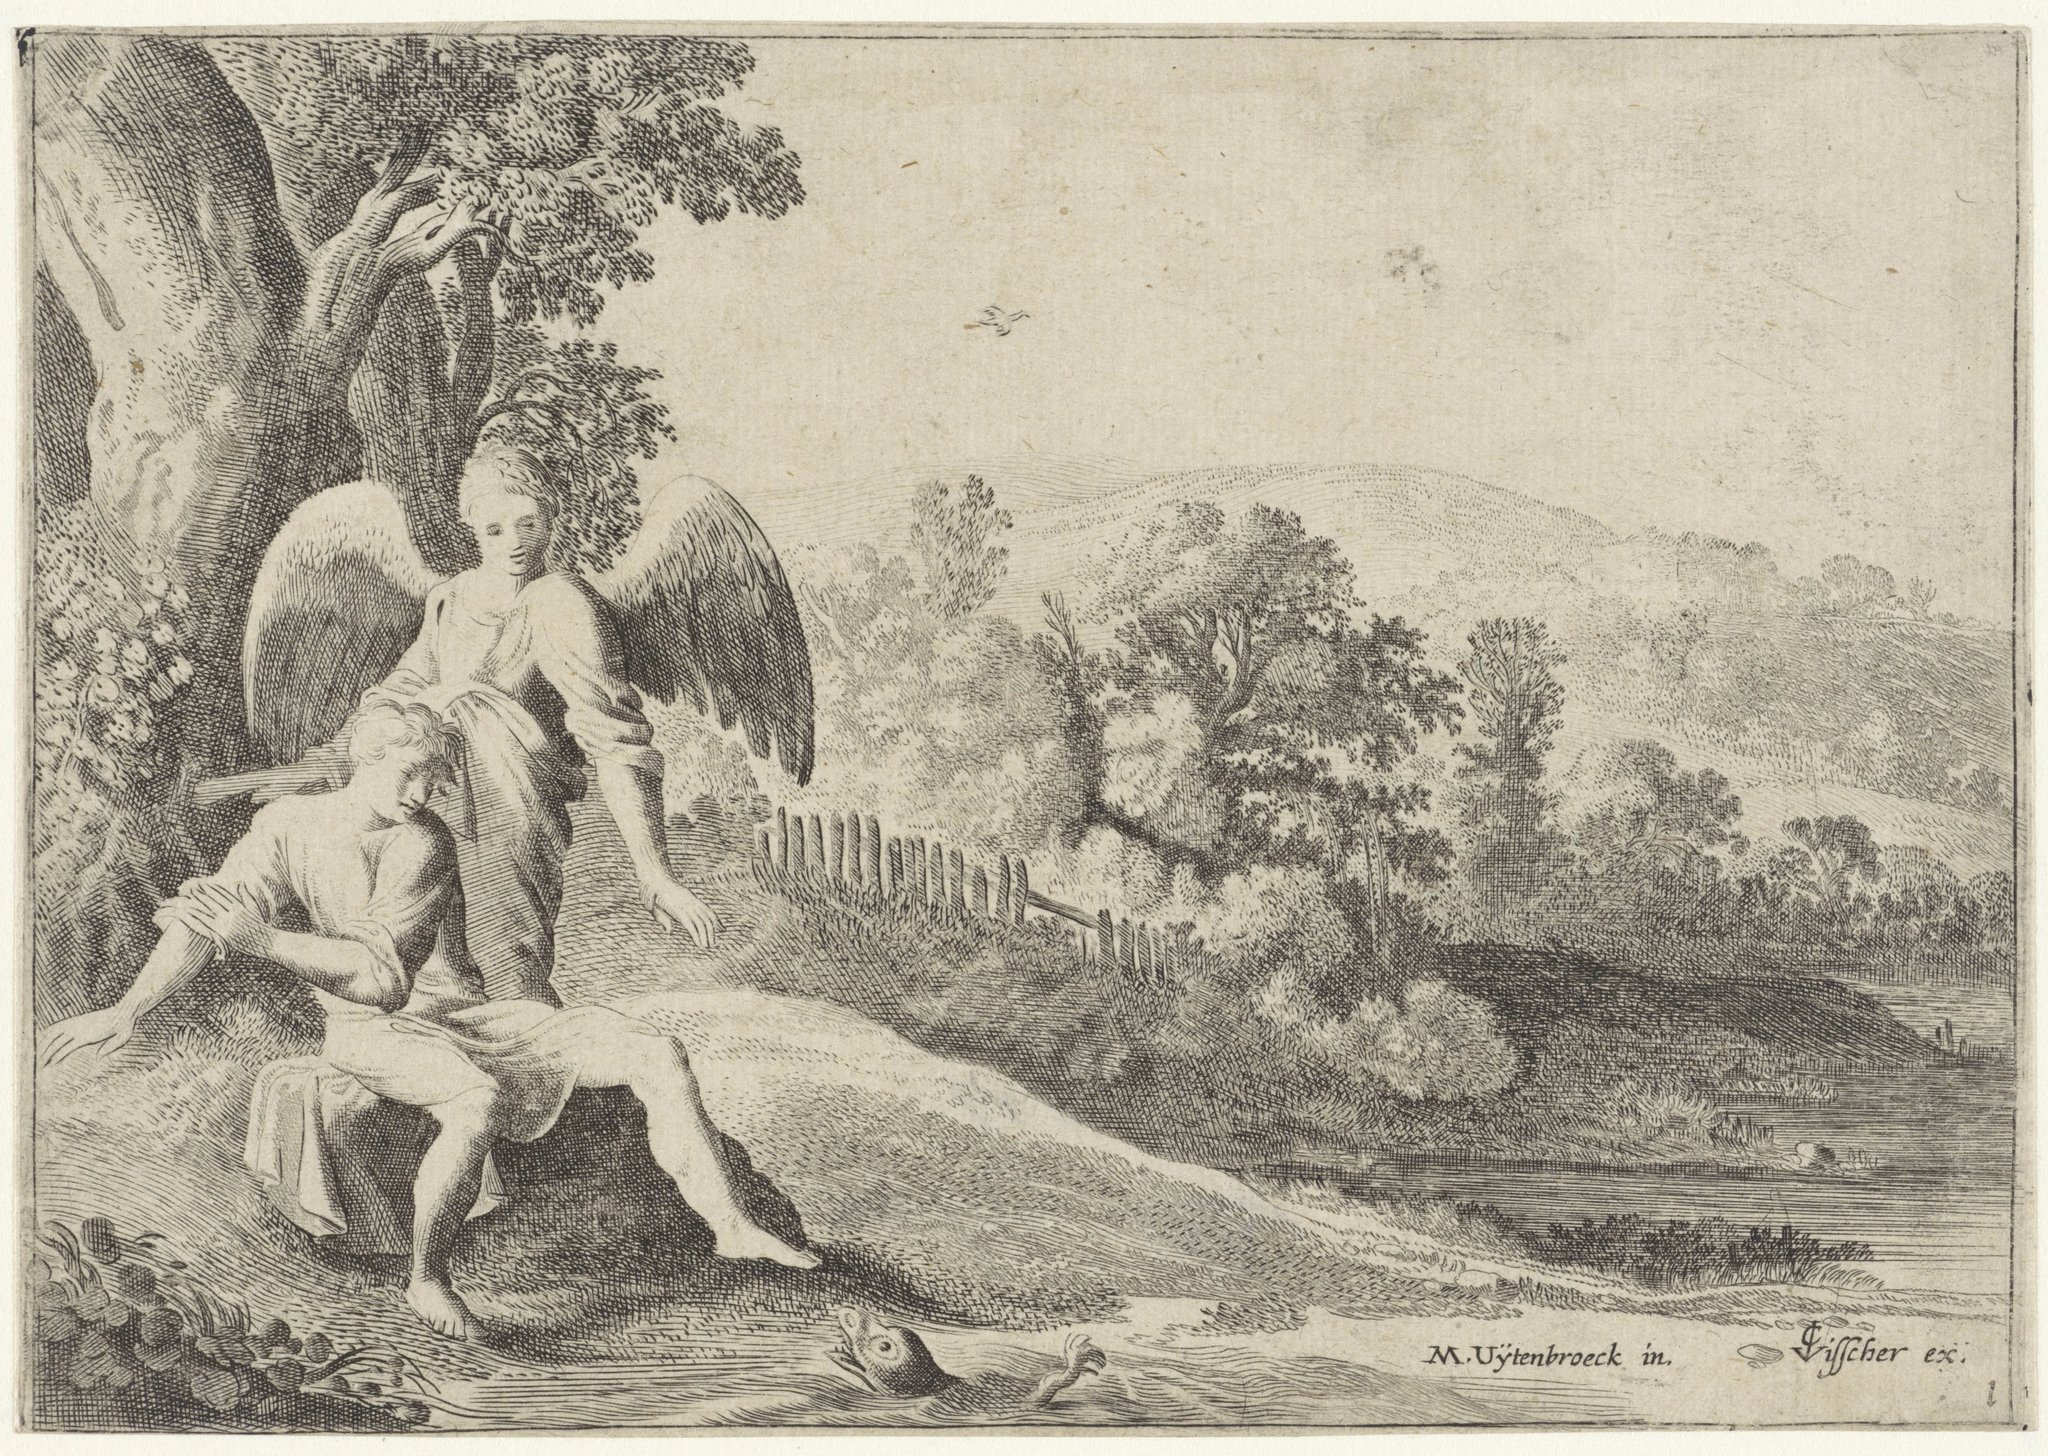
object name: print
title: Tobias schrikt van de vis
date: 1620-1697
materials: paper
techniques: engraving, etching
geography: the hague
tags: a large fish appears while tobias is washing his feet; he is frightened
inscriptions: collector's mark: Lugt 2228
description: Tobias zit langs de kant van het water en deinst terug als hij de vis in het water ziet. De engel staat achter hem. Genummerd als 1 in de rechterbenedenhoek.